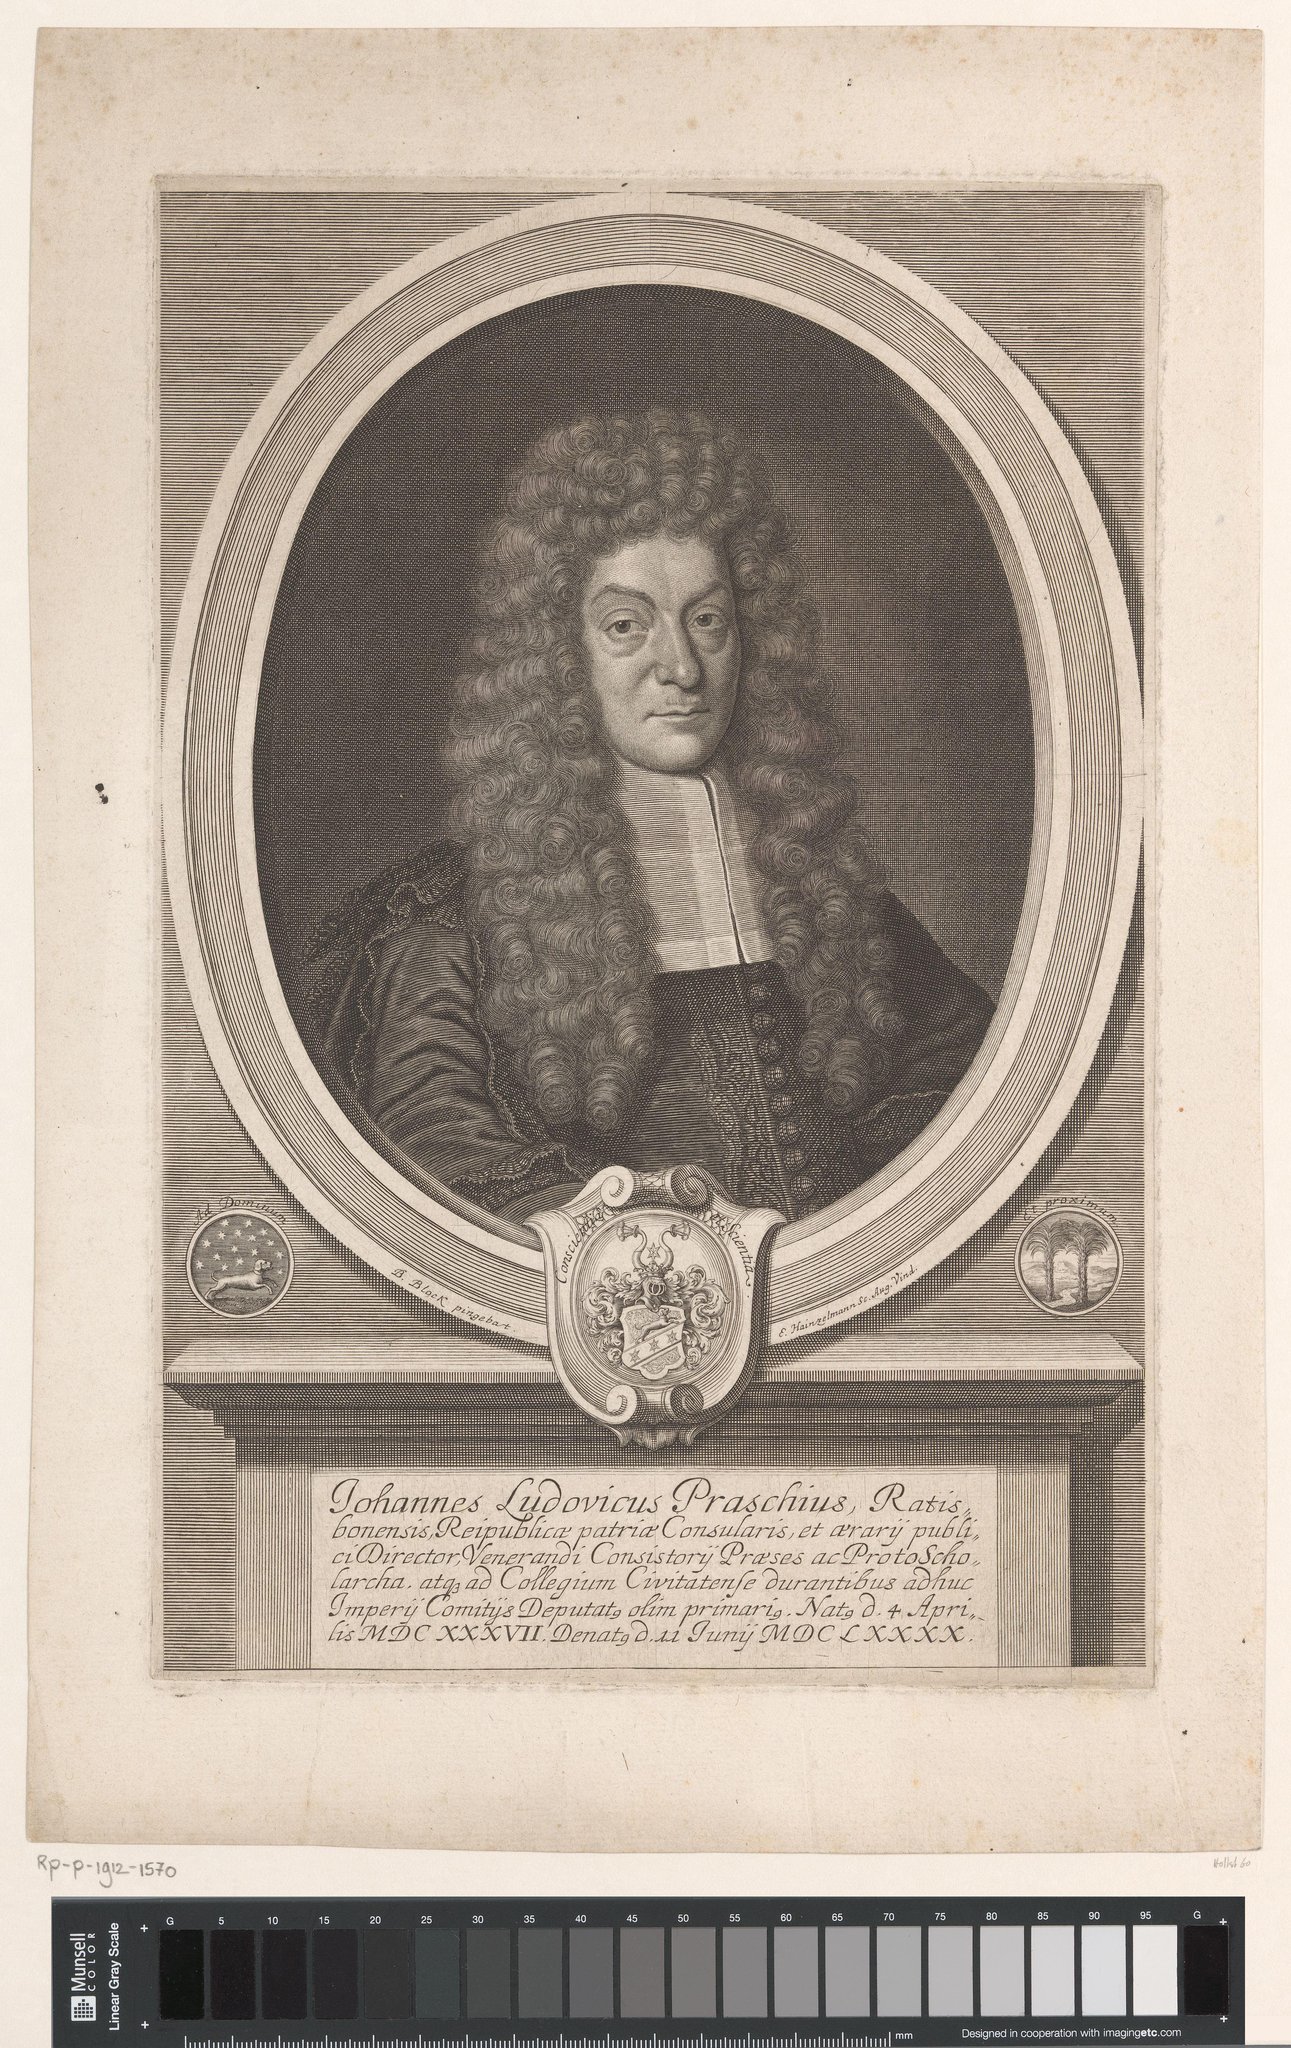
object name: print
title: Portret van Johann Ludwig Prasch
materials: paper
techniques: engraving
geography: augsburg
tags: historical persons, trees: palm-tree, abstract ideas and concepts (+ emblematical representation of concept), armorial bearing, heraldry, dog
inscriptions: collector's mark: Lugt 2228